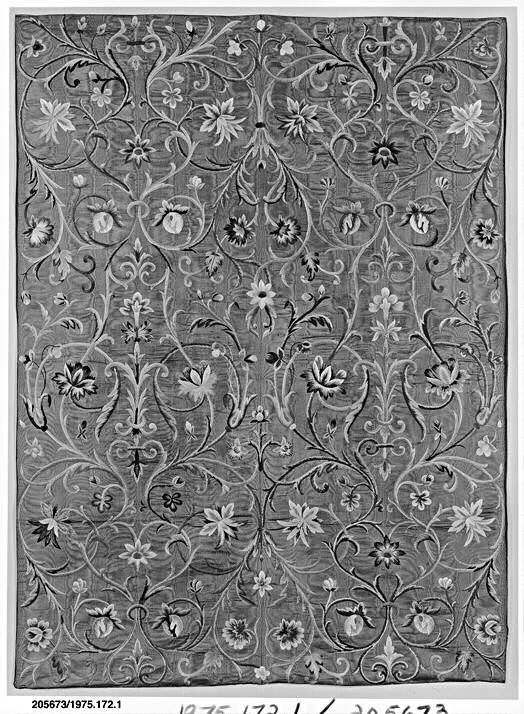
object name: panel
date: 1801-1900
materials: silk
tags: flowers